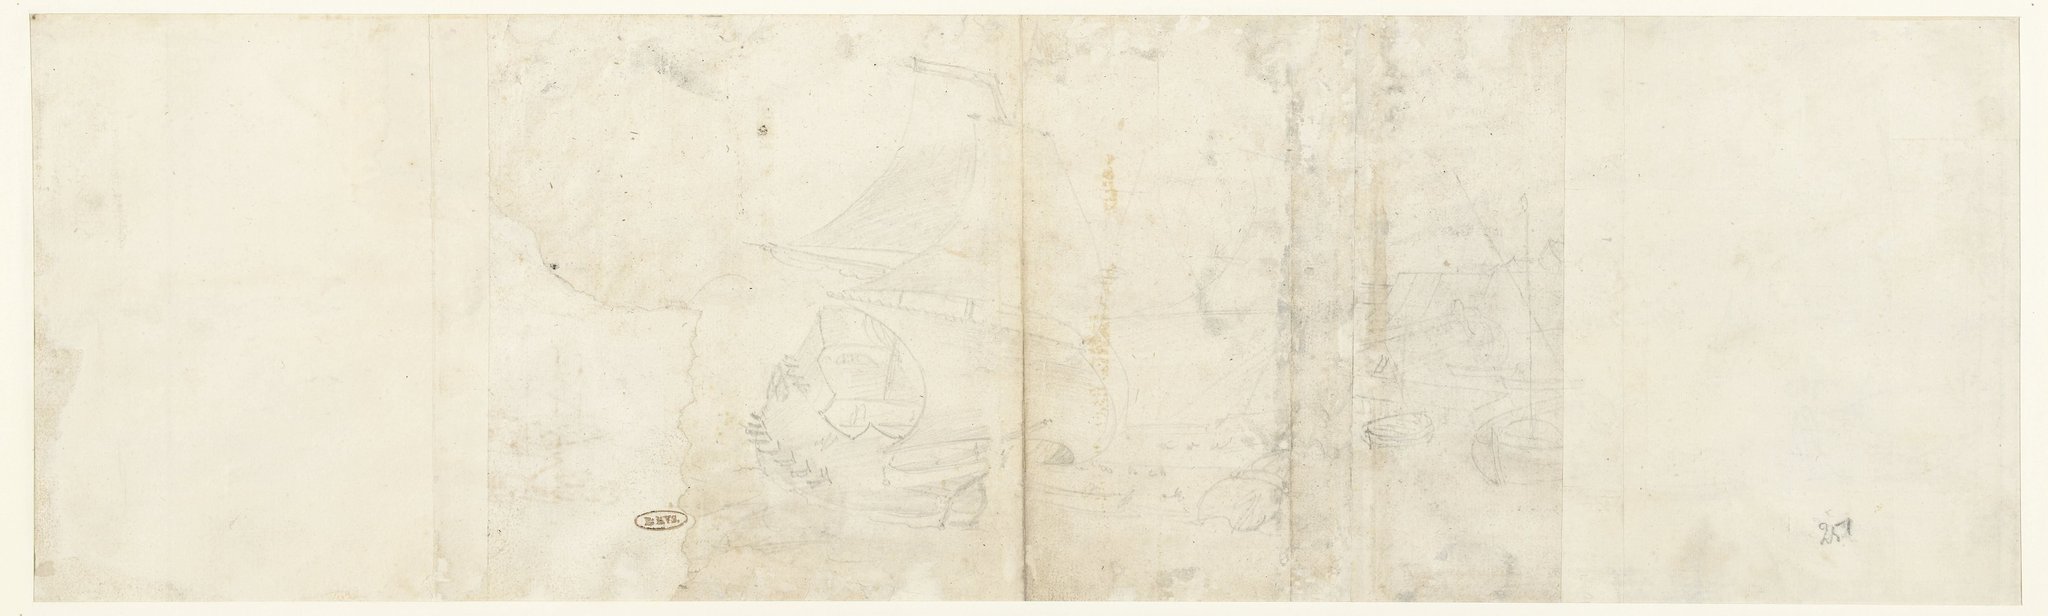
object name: drawing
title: Enkele zeilschepen en kleinere boten in een haven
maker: joris hoefnagel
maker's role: draughtsman, painter, print maker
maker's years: 1542-1600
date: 1595-1601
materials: ink, paper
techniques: brush, pen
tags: harbour